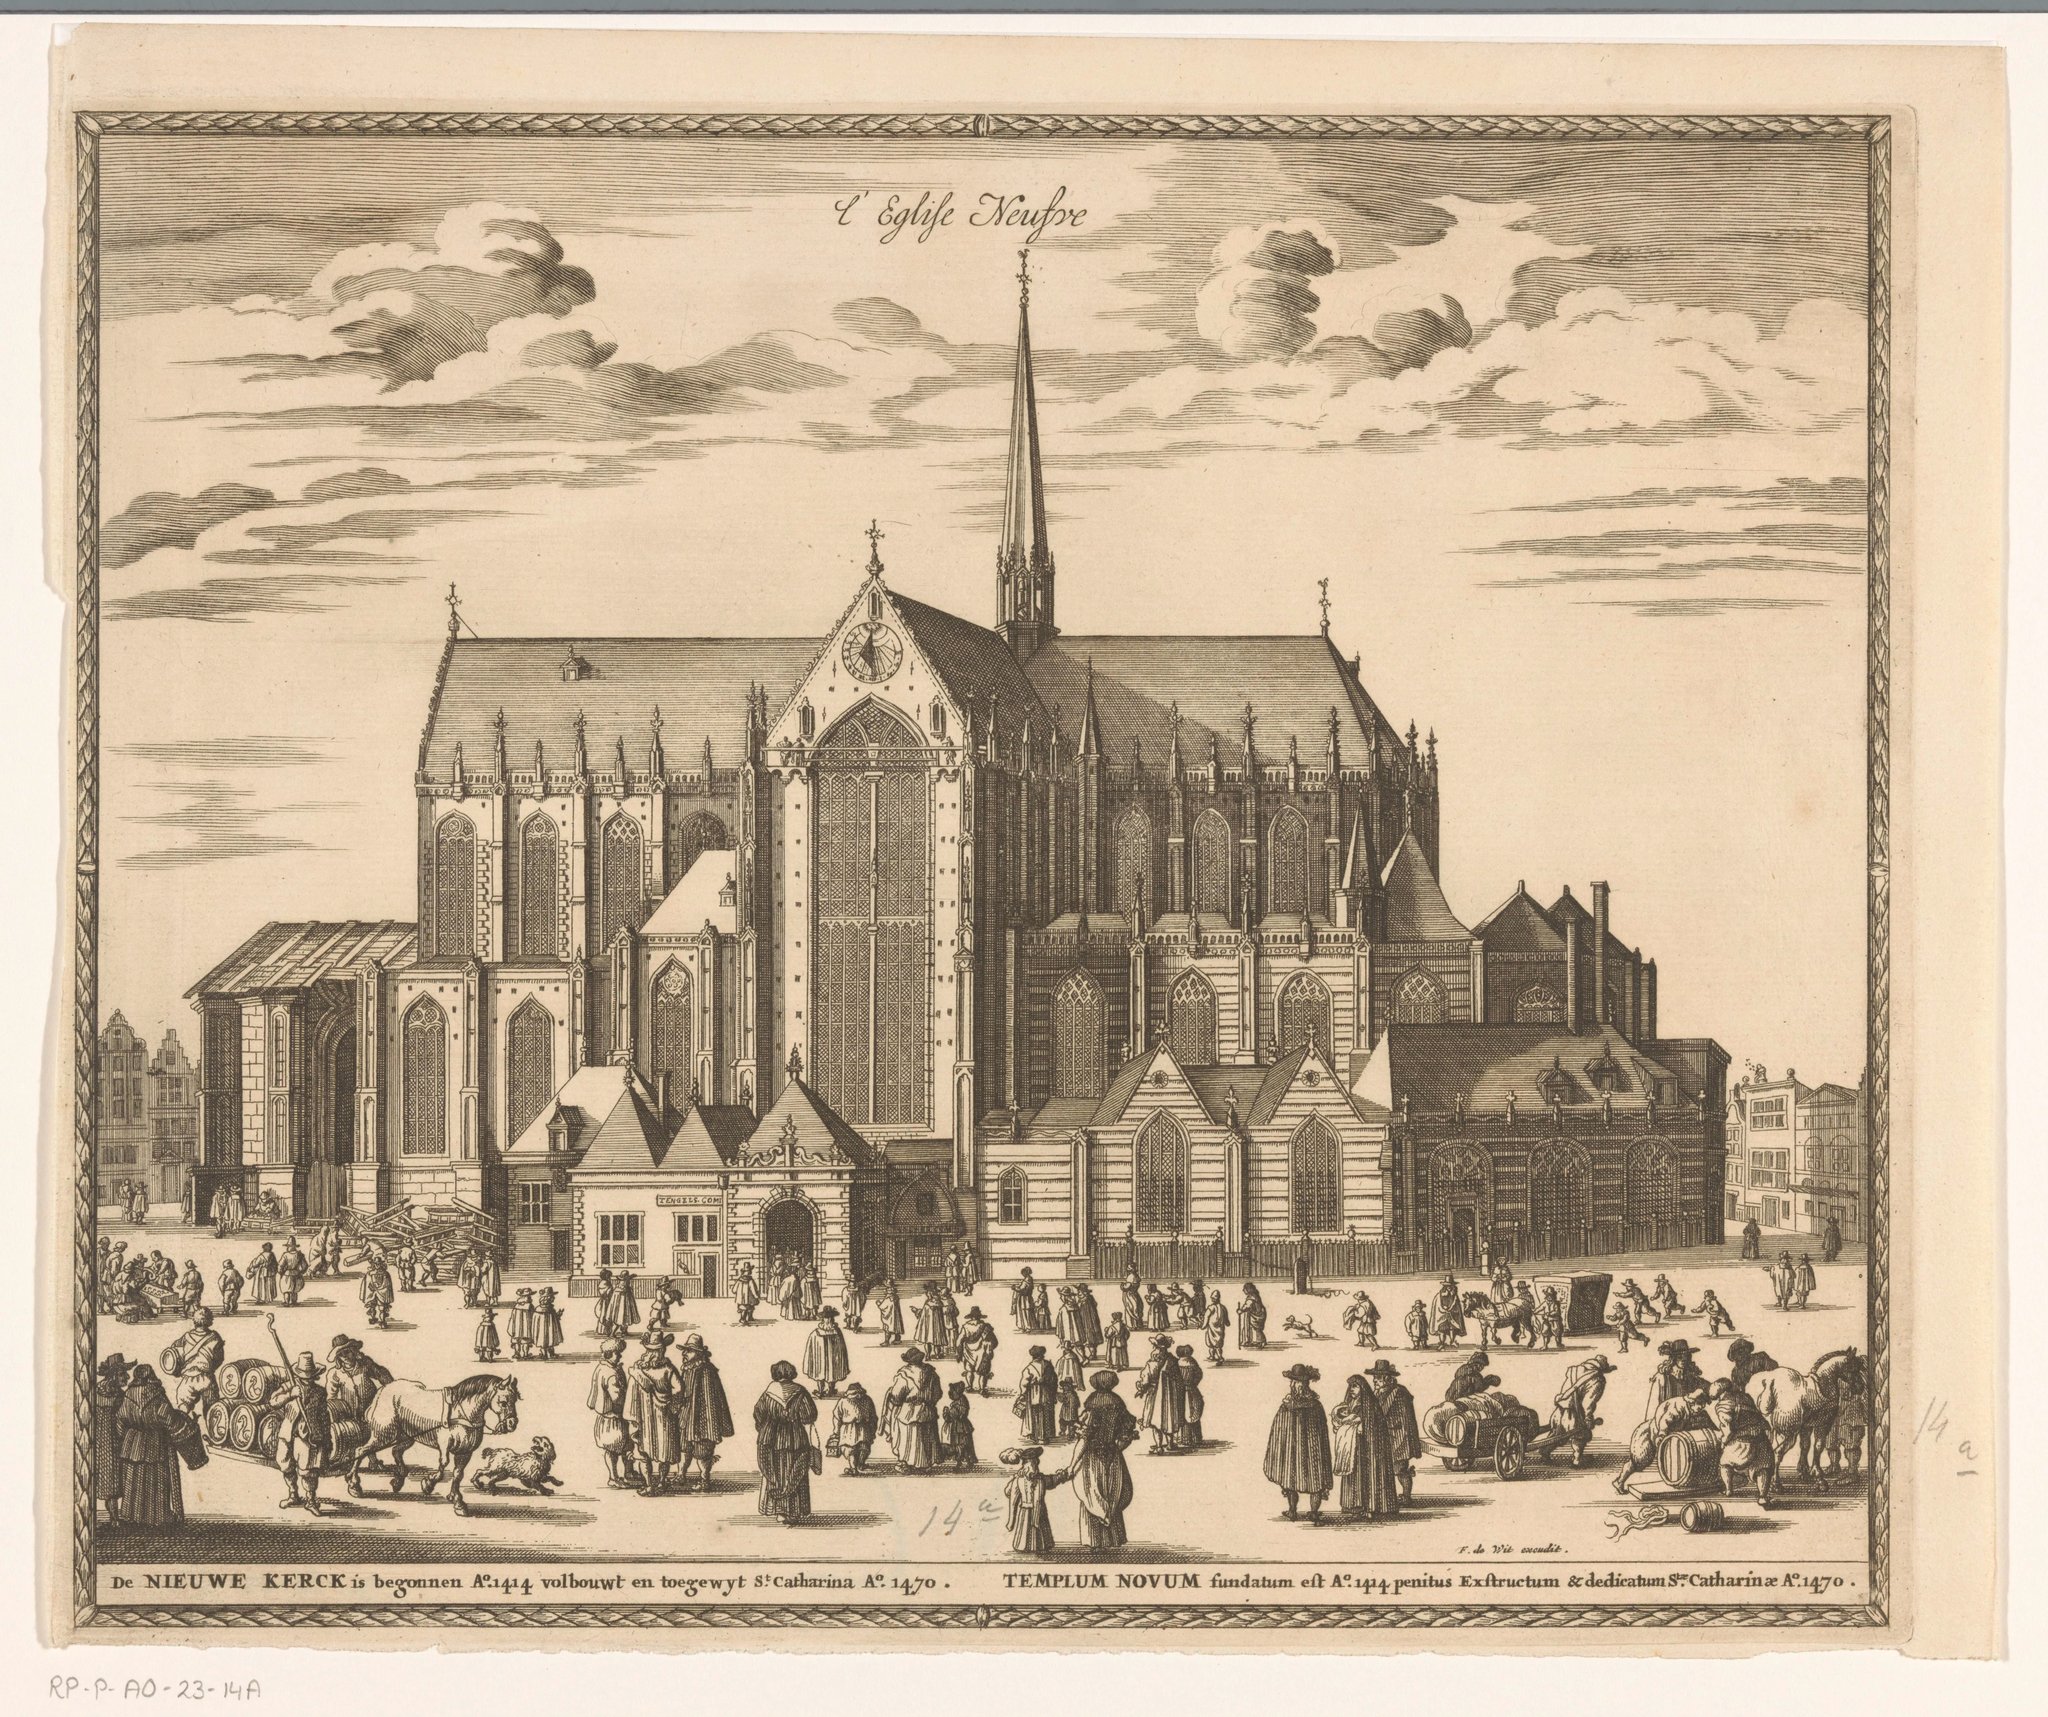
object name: print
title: De Nieuwe Kerck is begonnen Ao. 1414 volbouwt en toegewyt St. Catharina Ao. 1470 / Templum Novum fundatum est Ao. 1414 penitus Exstructum & dedicatum Stae. Catharinae Ao. 1470 / l' Eglise Neufve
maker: Anonymous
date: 1662-1728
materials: paper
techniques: engraving, etching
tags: church (exterior), square, place, circus, etc. (+ city(-scape) with figures, staffage)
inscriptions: collector's mark: Lugt 2228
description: Prent ook gebruikt in: La celebre ville d'Amsterdam, representée dans toute sa splendeur et sa magnificence (...) / De heerlykheid der wyd-vermaerde stad Amsterdam (…). Leiden: Pieter van der Aa, s.a. En in: Aa, Pieter van der. Europa. Leiden: Pieter van der Aa, s.a. [ca. 1715]. En in: Aa, Pieter van der. La galerie agreable du monde (...). 66 delen. Leiden: Pieter van der Aa, 1728, dl. 17. Zie ook RP-P-AO-23-14.